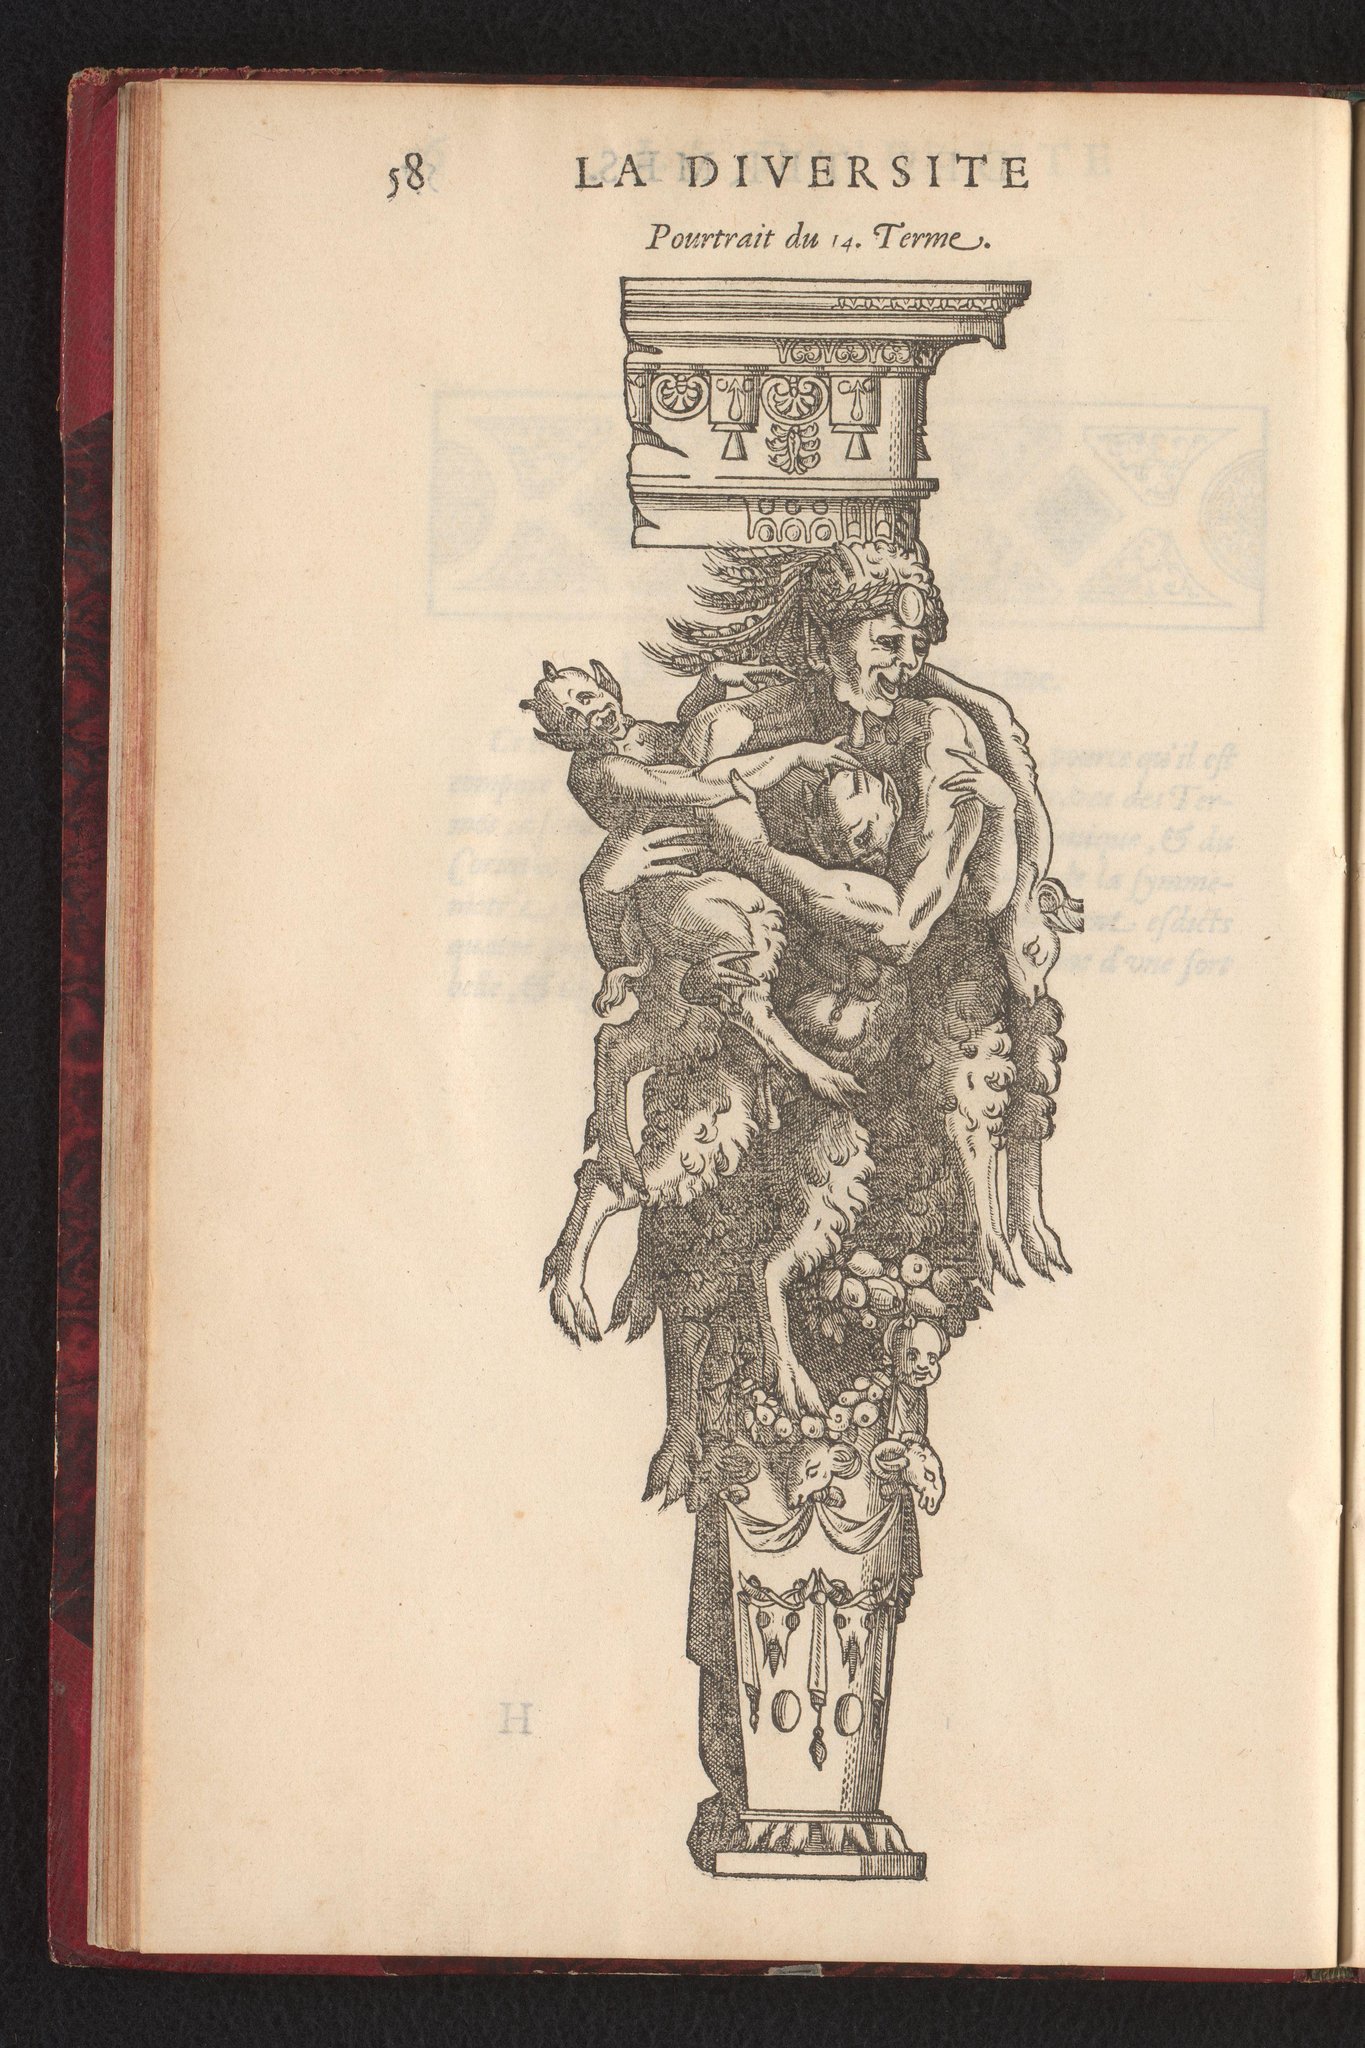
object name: album leaf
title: Oeuvre de la diversité des termes, dont on use en architecture, reduict en ordre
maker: Anonymous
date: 1572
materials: paper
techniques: letterpress printing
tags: herms (garden ornaments), pedestal of a piece of sculpture (perhaps in the form of a herm), satyr(s) (in general), herm: pillar with the head of mercury, patron of travellers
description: Linksboven genummerd: 58. Volgens de toelichting op pagina 60 gaat het hier om de Composiete orde. Prent maakt deel uit van een album.